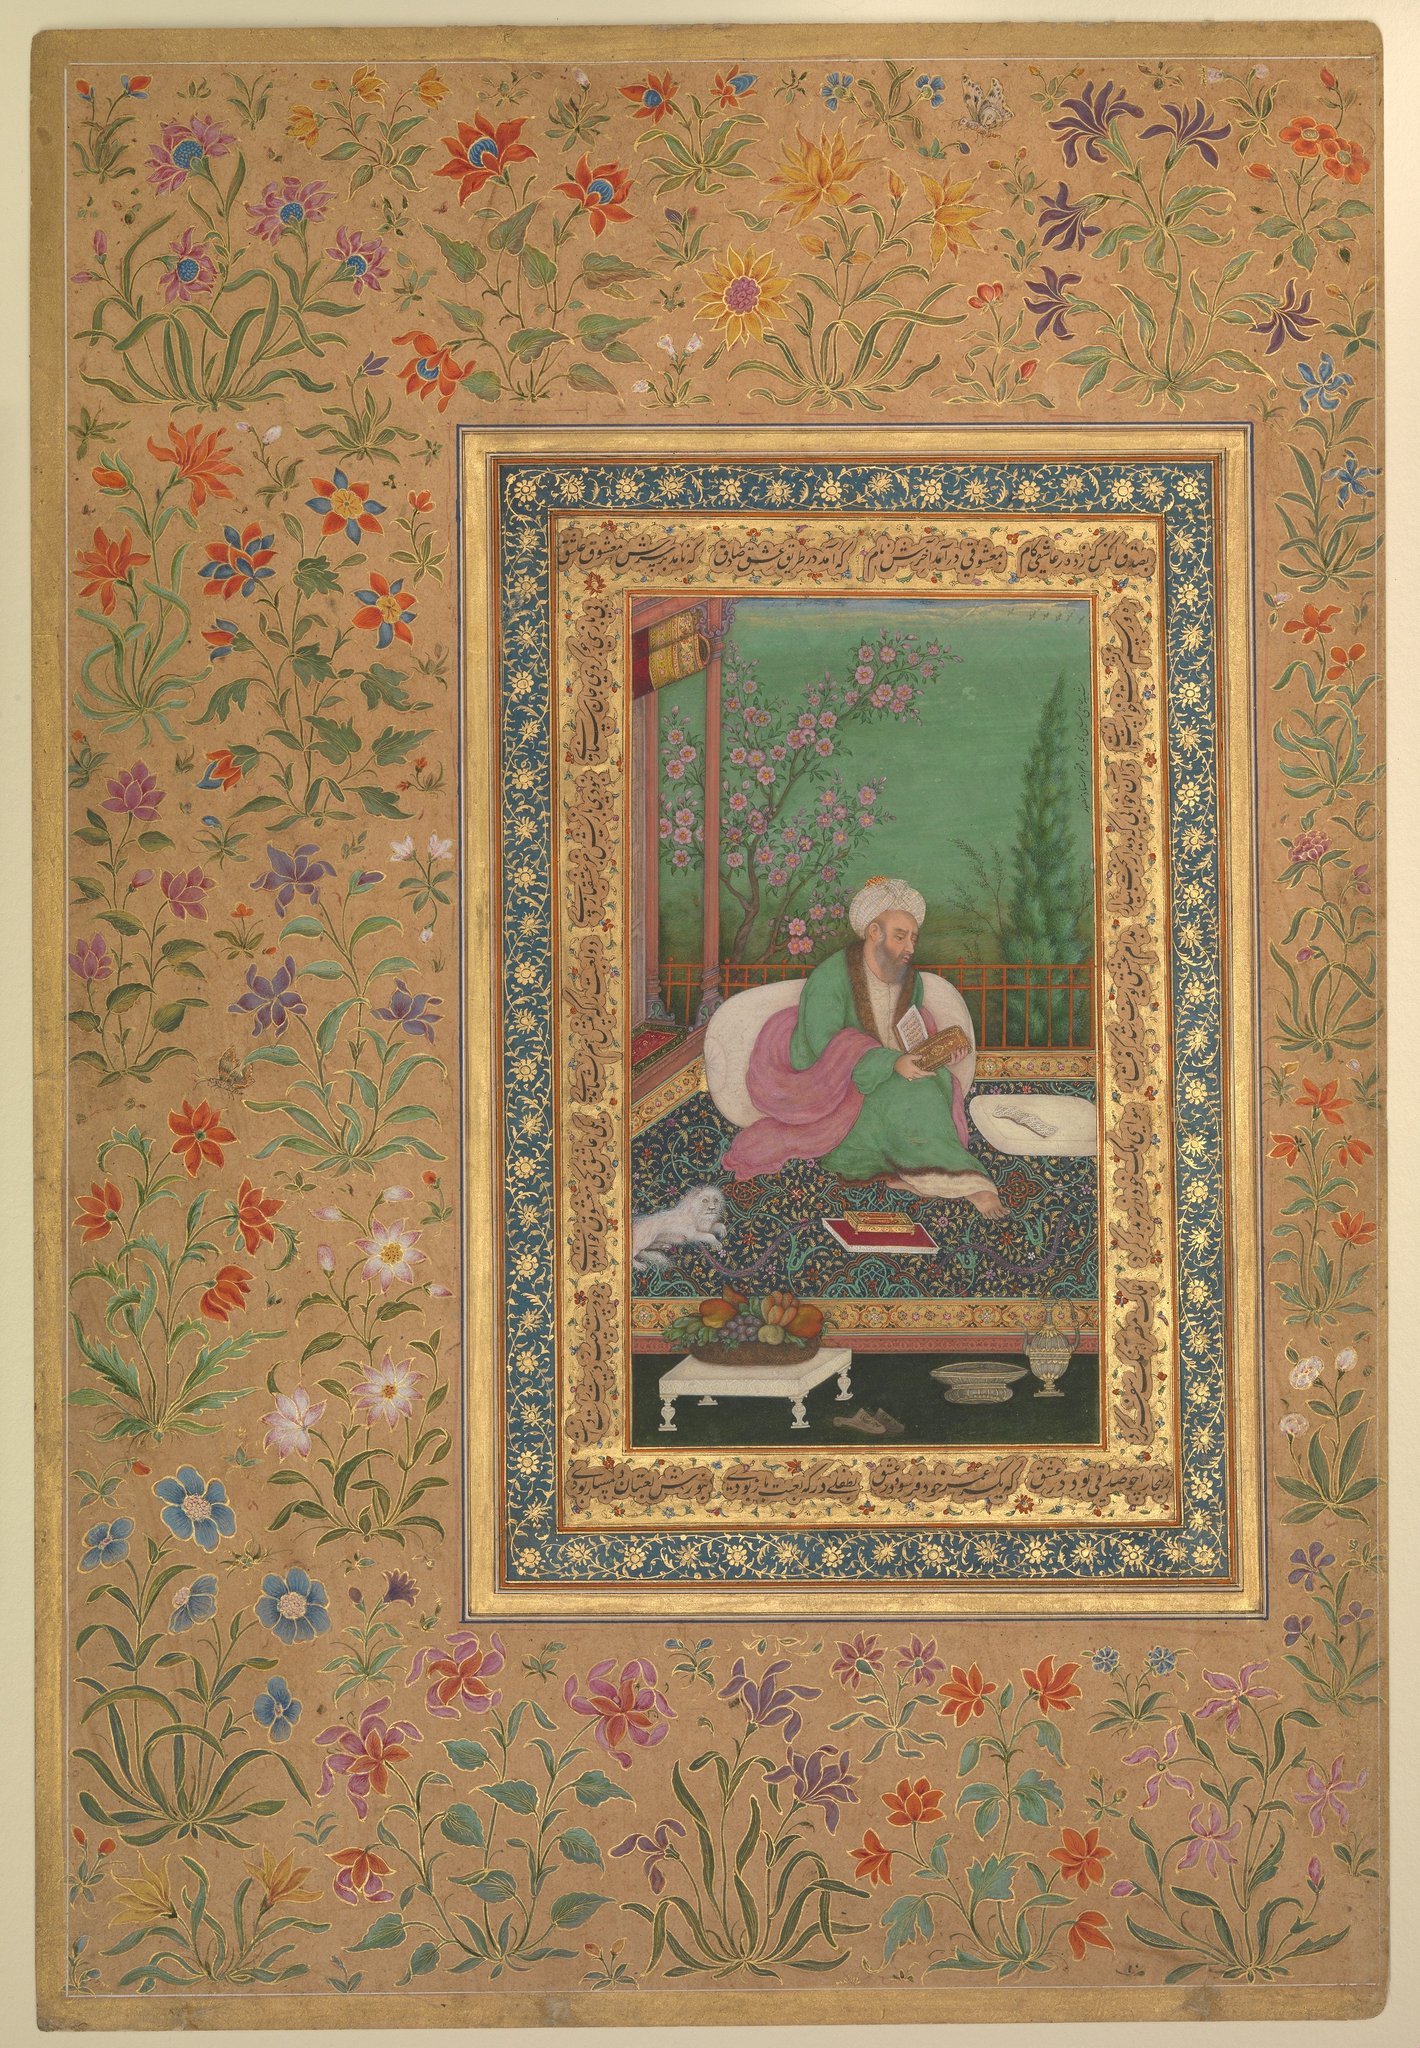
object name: album leaf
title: "Haji Husain Bukhari", Folio from the Shah Jahan Album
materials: gold, ink, paper, watercolor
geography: india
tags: men,flowers